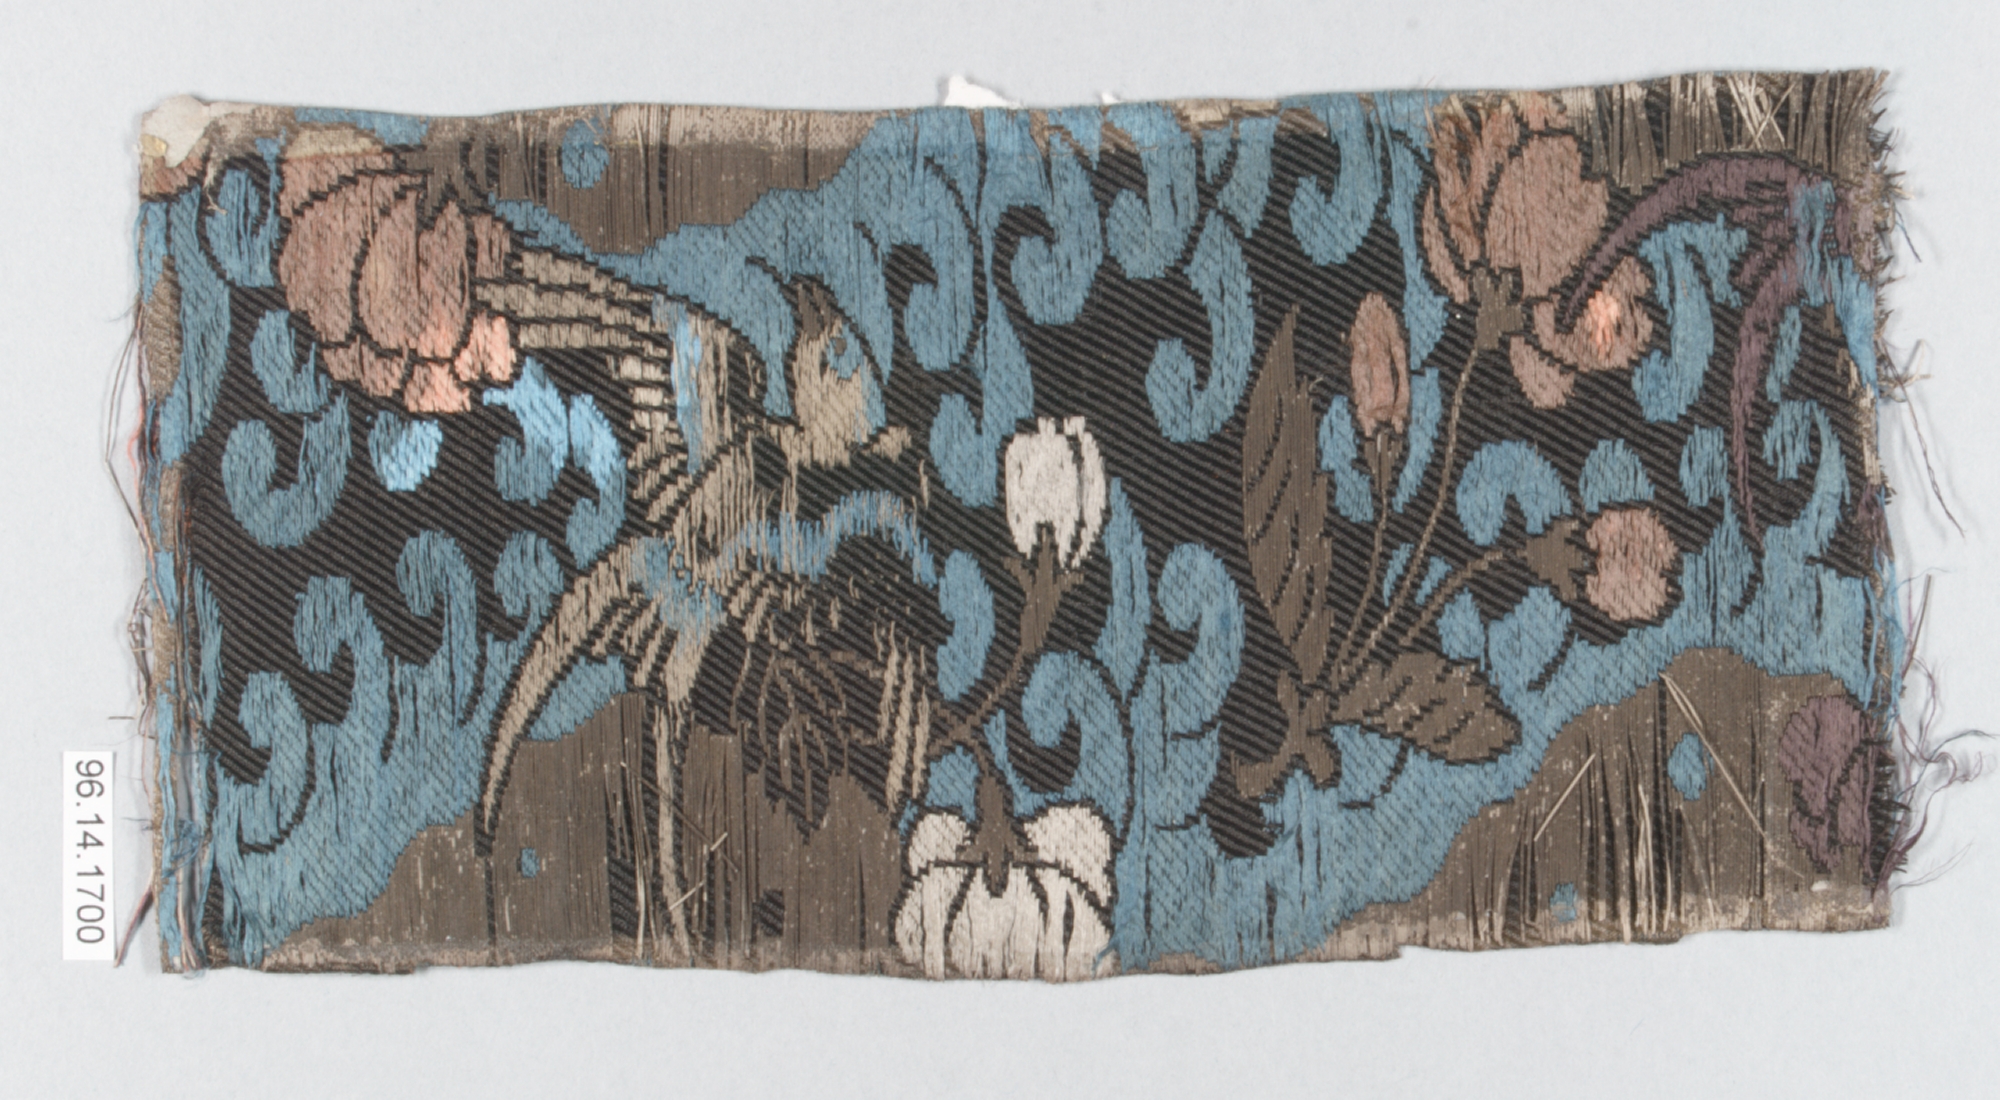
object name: piece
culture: japanese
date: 1701-1900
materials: metal thread, silk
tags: flowers